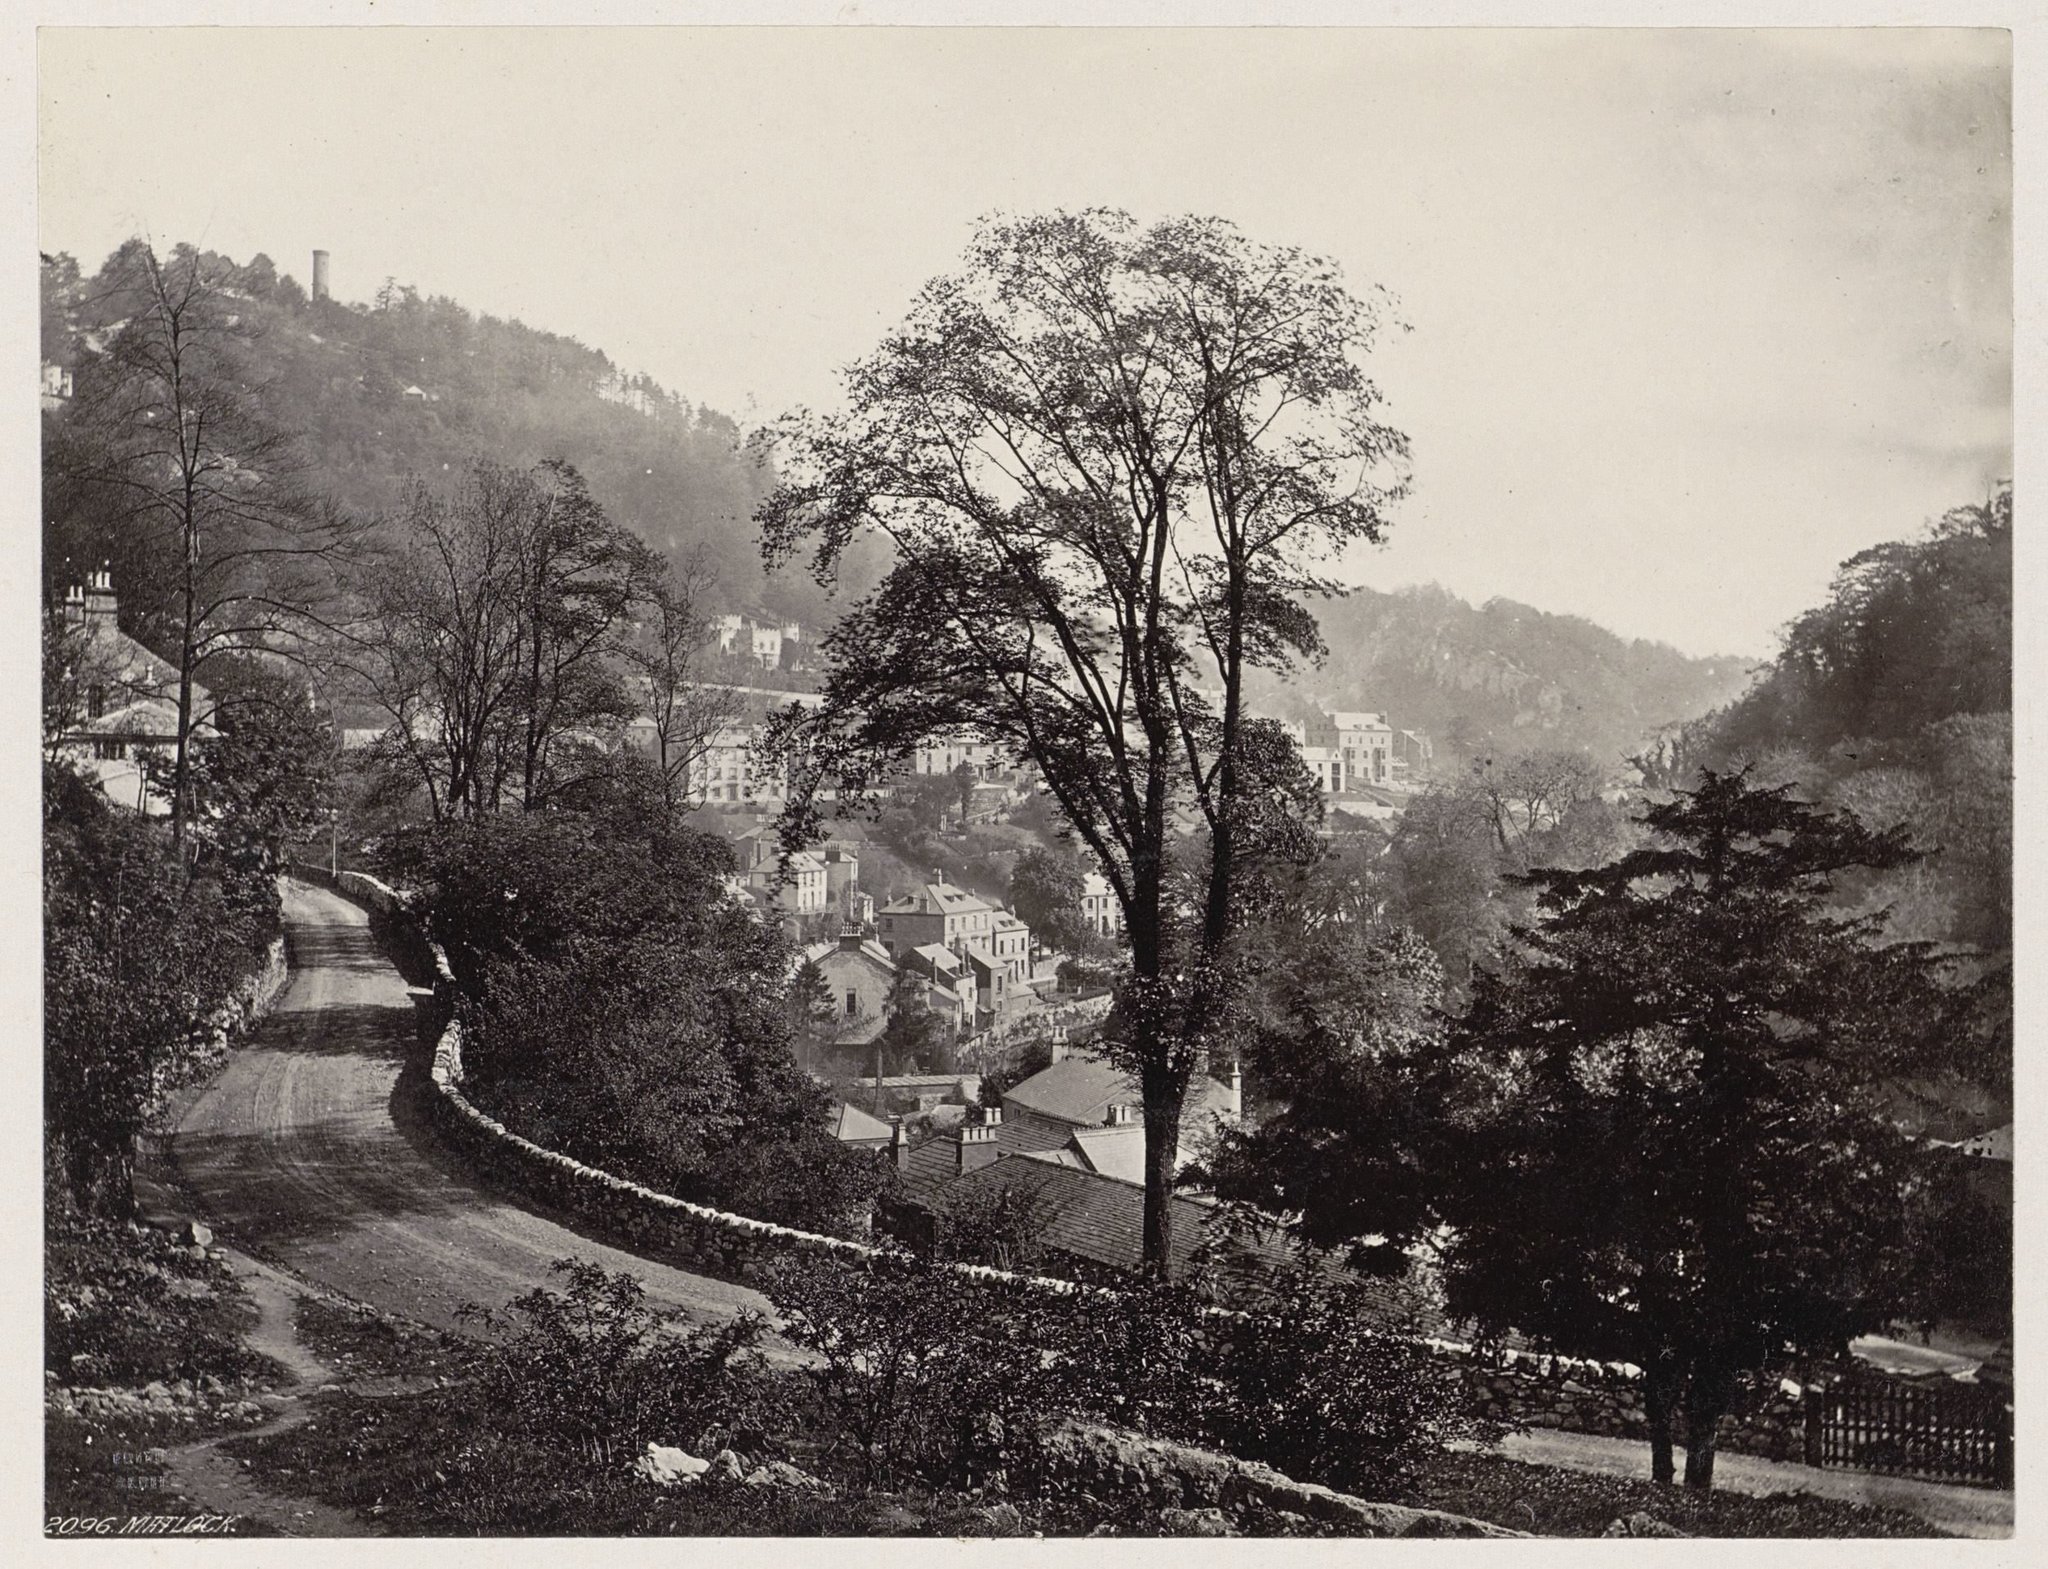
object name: photograph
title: Matlock England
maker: Anonymous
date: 1878-1890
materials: photographic support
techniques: albumen print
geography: matlock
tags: prospect of village, silhouette of village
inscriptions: check stamp: ‘Frith's Series’, negative number: ‘2096’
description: Onderdeel van Reisalbum Europese steden, vermoedelijk Zweeds.